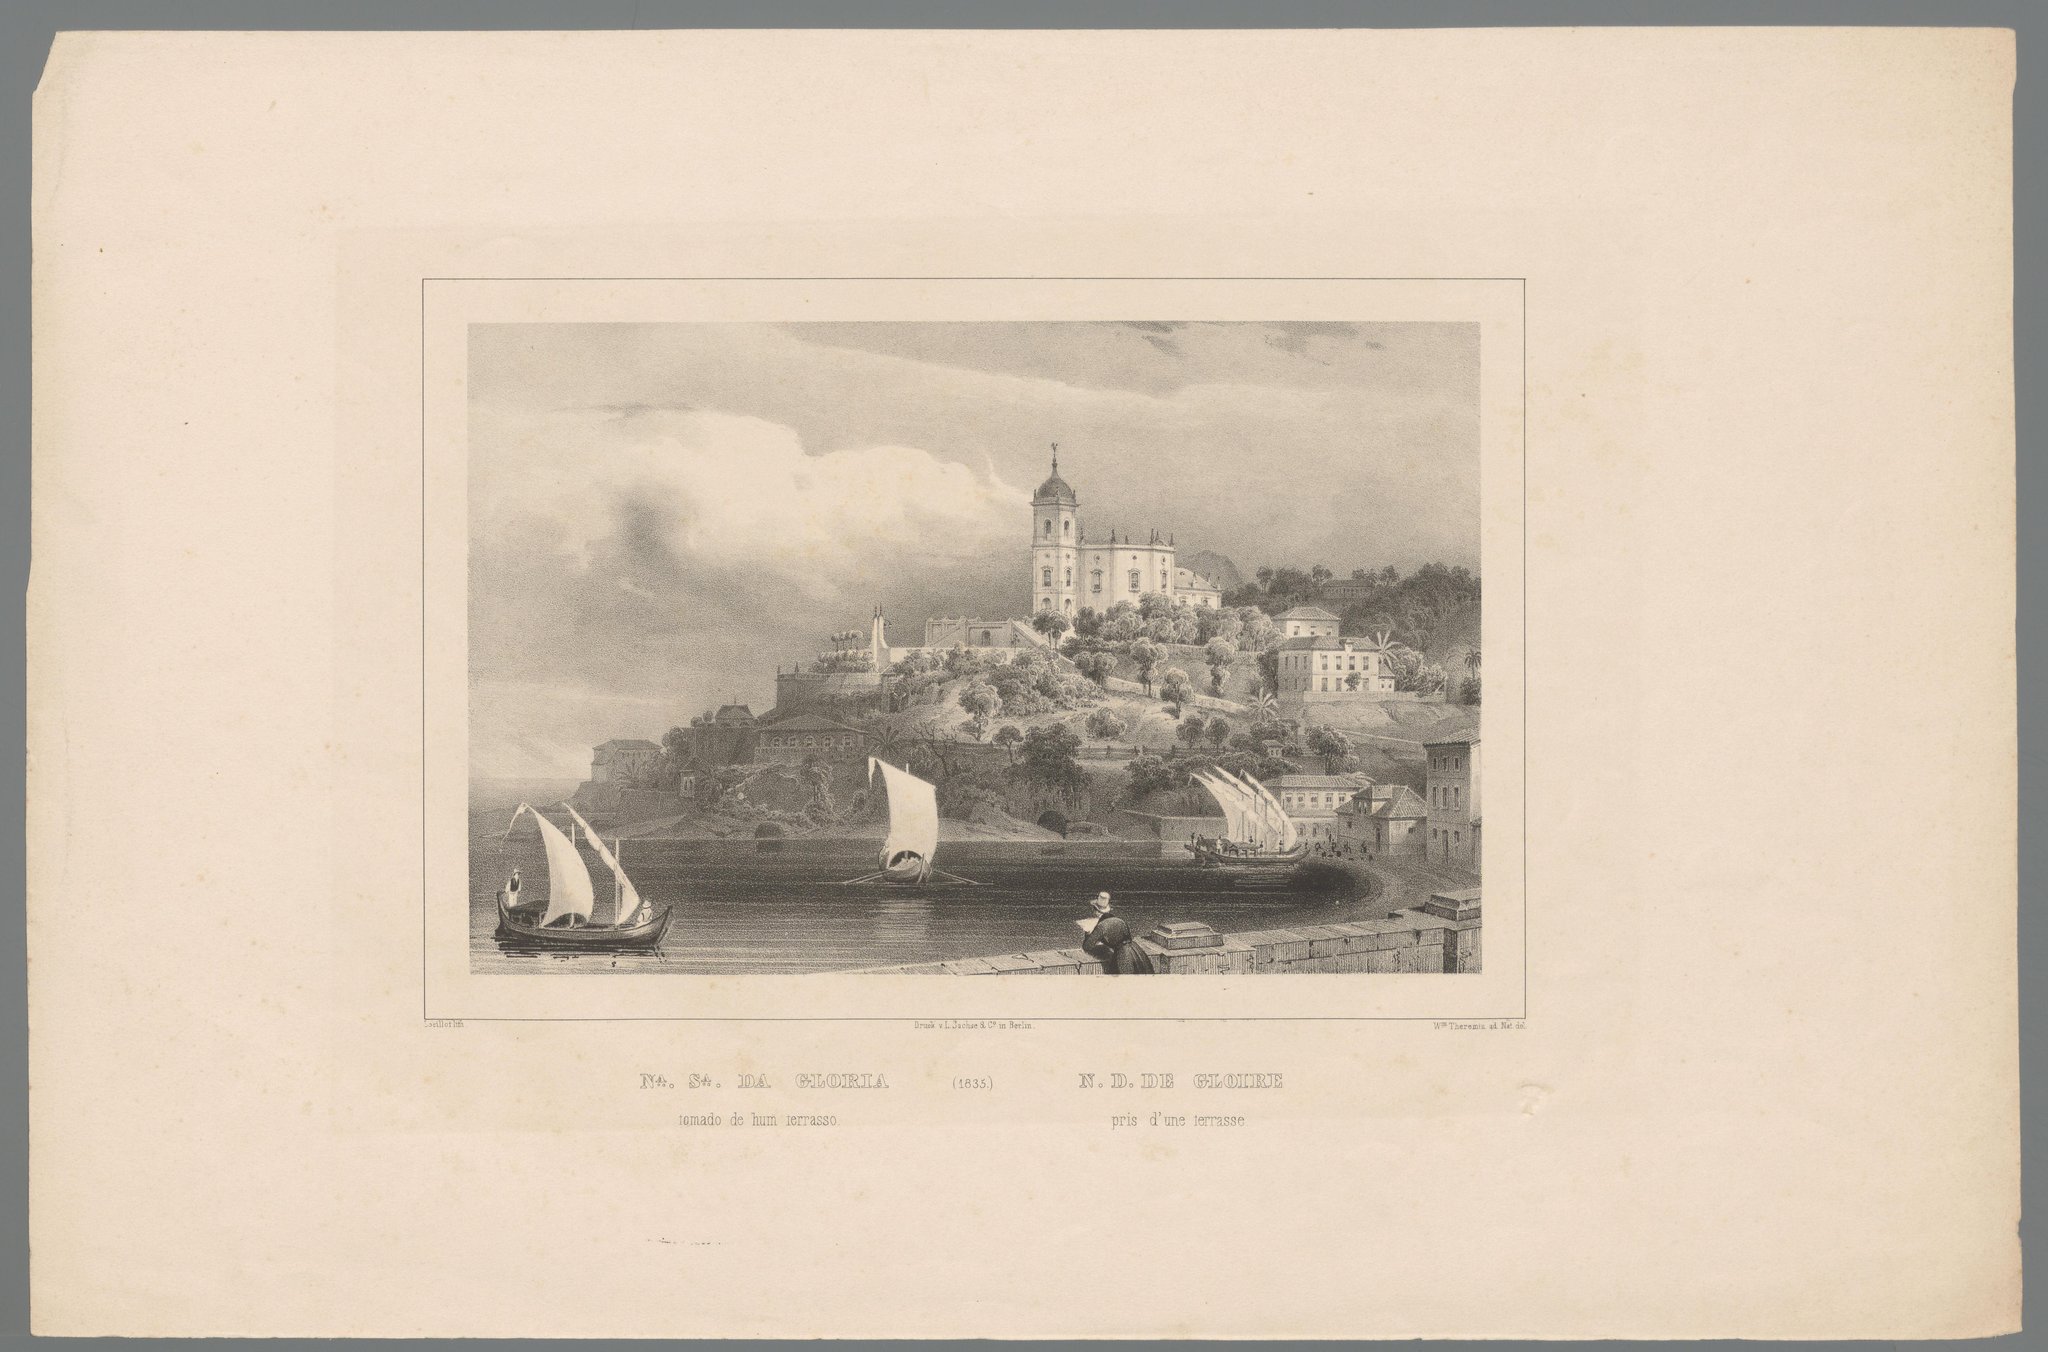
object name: print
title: Gezichten op Rio de Janeiro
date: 1835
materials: paper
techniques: lithograph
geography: berlin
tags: draughtsman at work - cc - out of doors, mountains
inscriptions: collector's mark: ‘T’, collector's mark: Lugt 2228